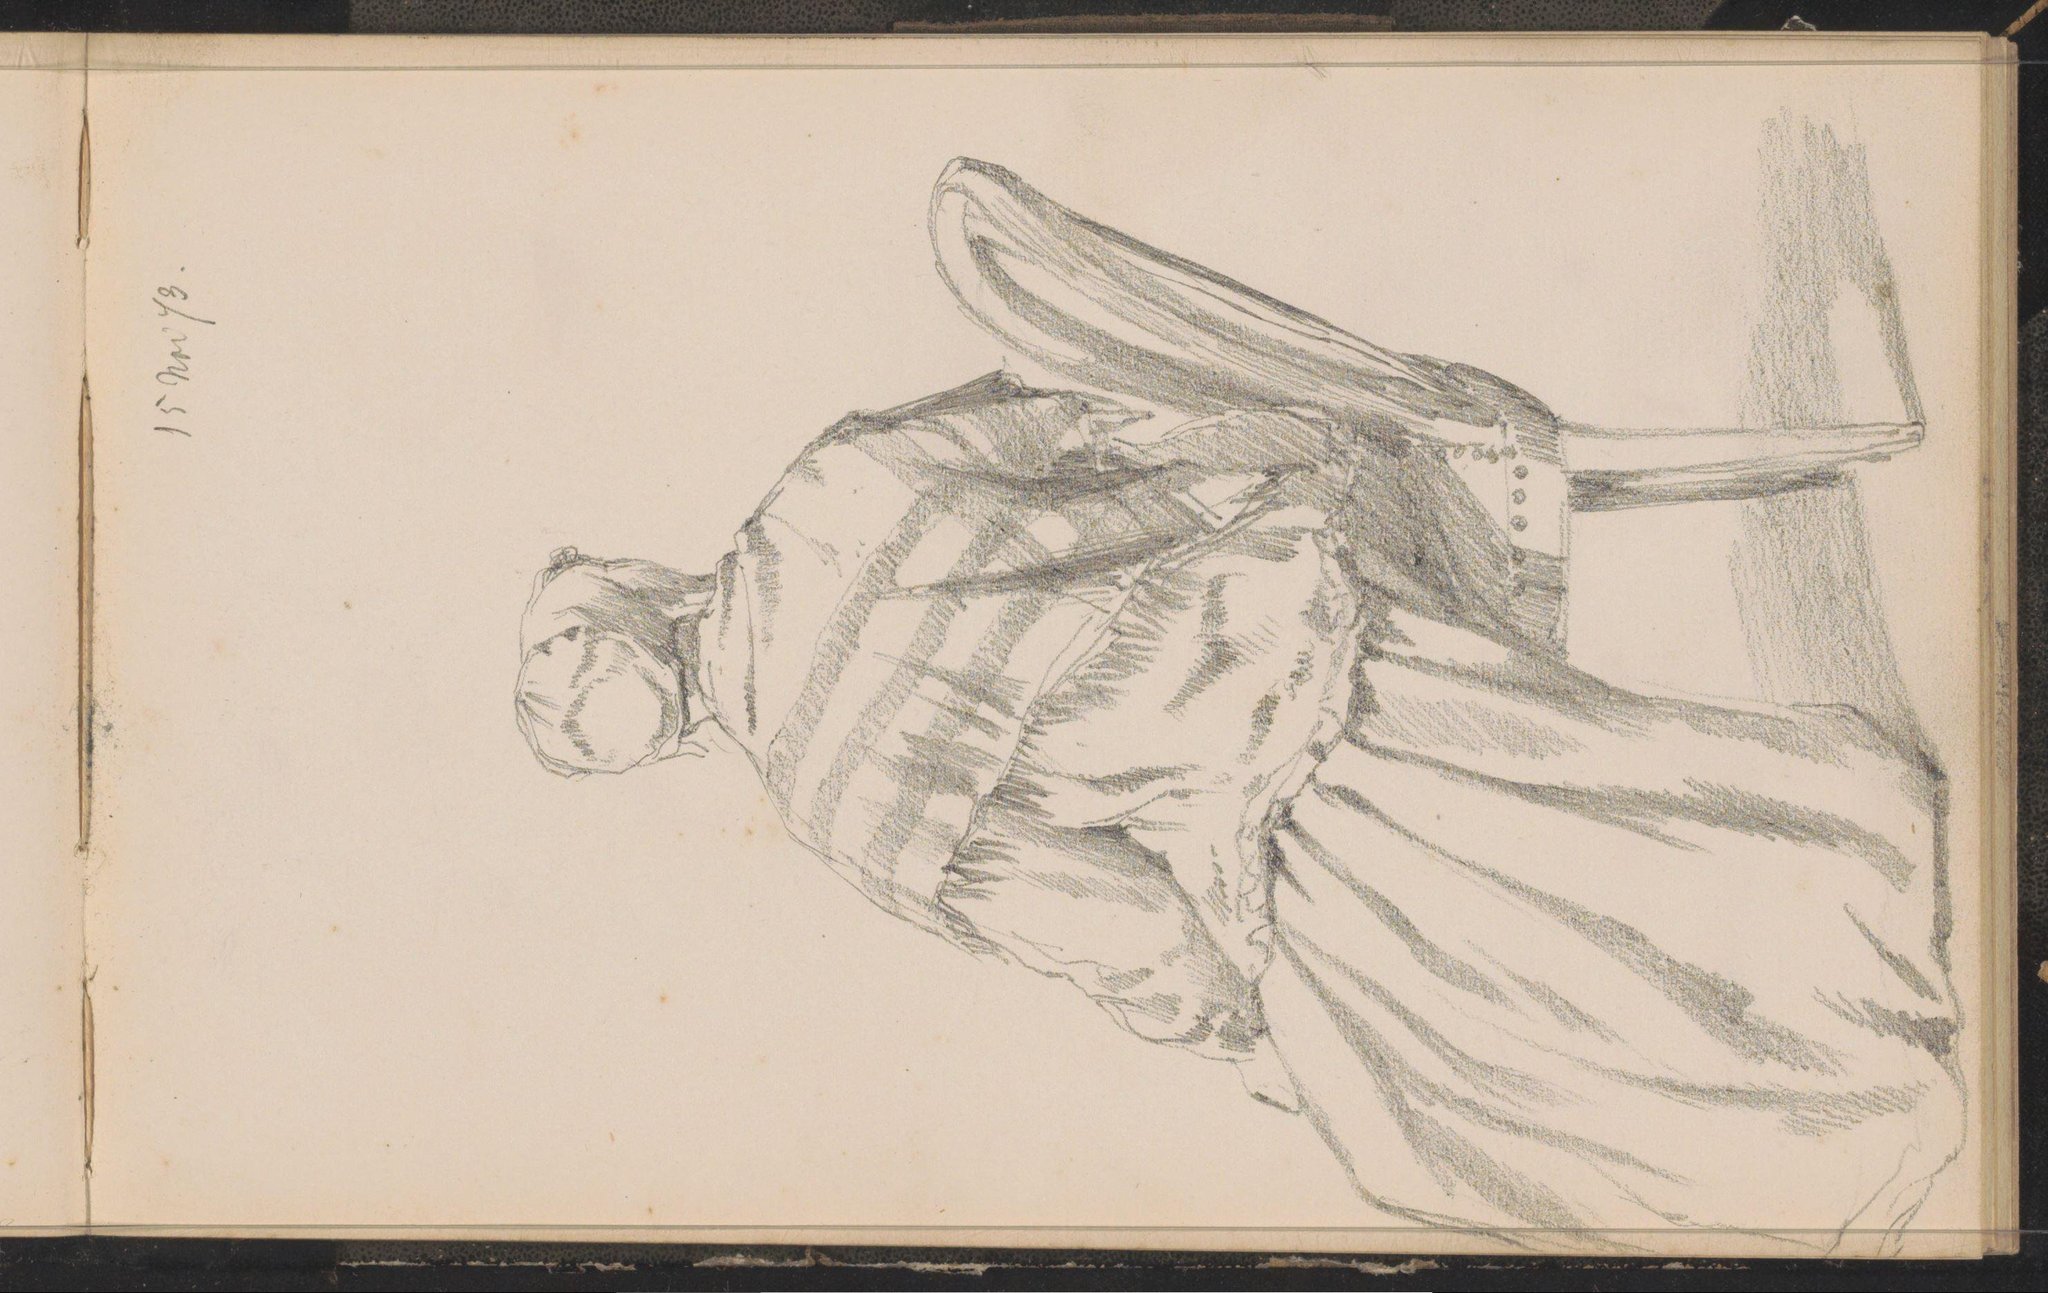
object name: sketchbook leaf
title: Zittende vrouw op een stoel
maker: cornelis springer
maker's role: draughtsman, painter, print maker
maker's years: 1817-1891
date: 1873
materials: paper, pencil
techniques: stumping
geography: netherlands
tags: sitting figure - aa - female human figure (+ back view), chair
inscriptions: date: ‘15 nov 73’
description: Een vrouw met een omslagdoek en een muts zit op een stoel. Blad 28 uit een schetsboek met 46 bladen.